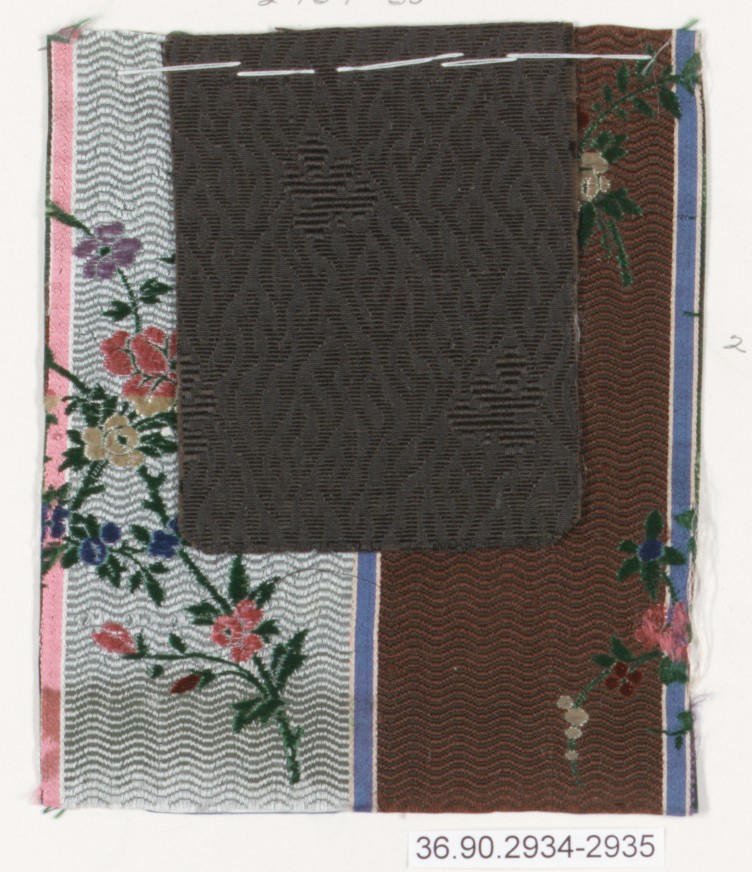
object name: piece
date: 1801-1900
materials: silk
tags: flowers,leaves